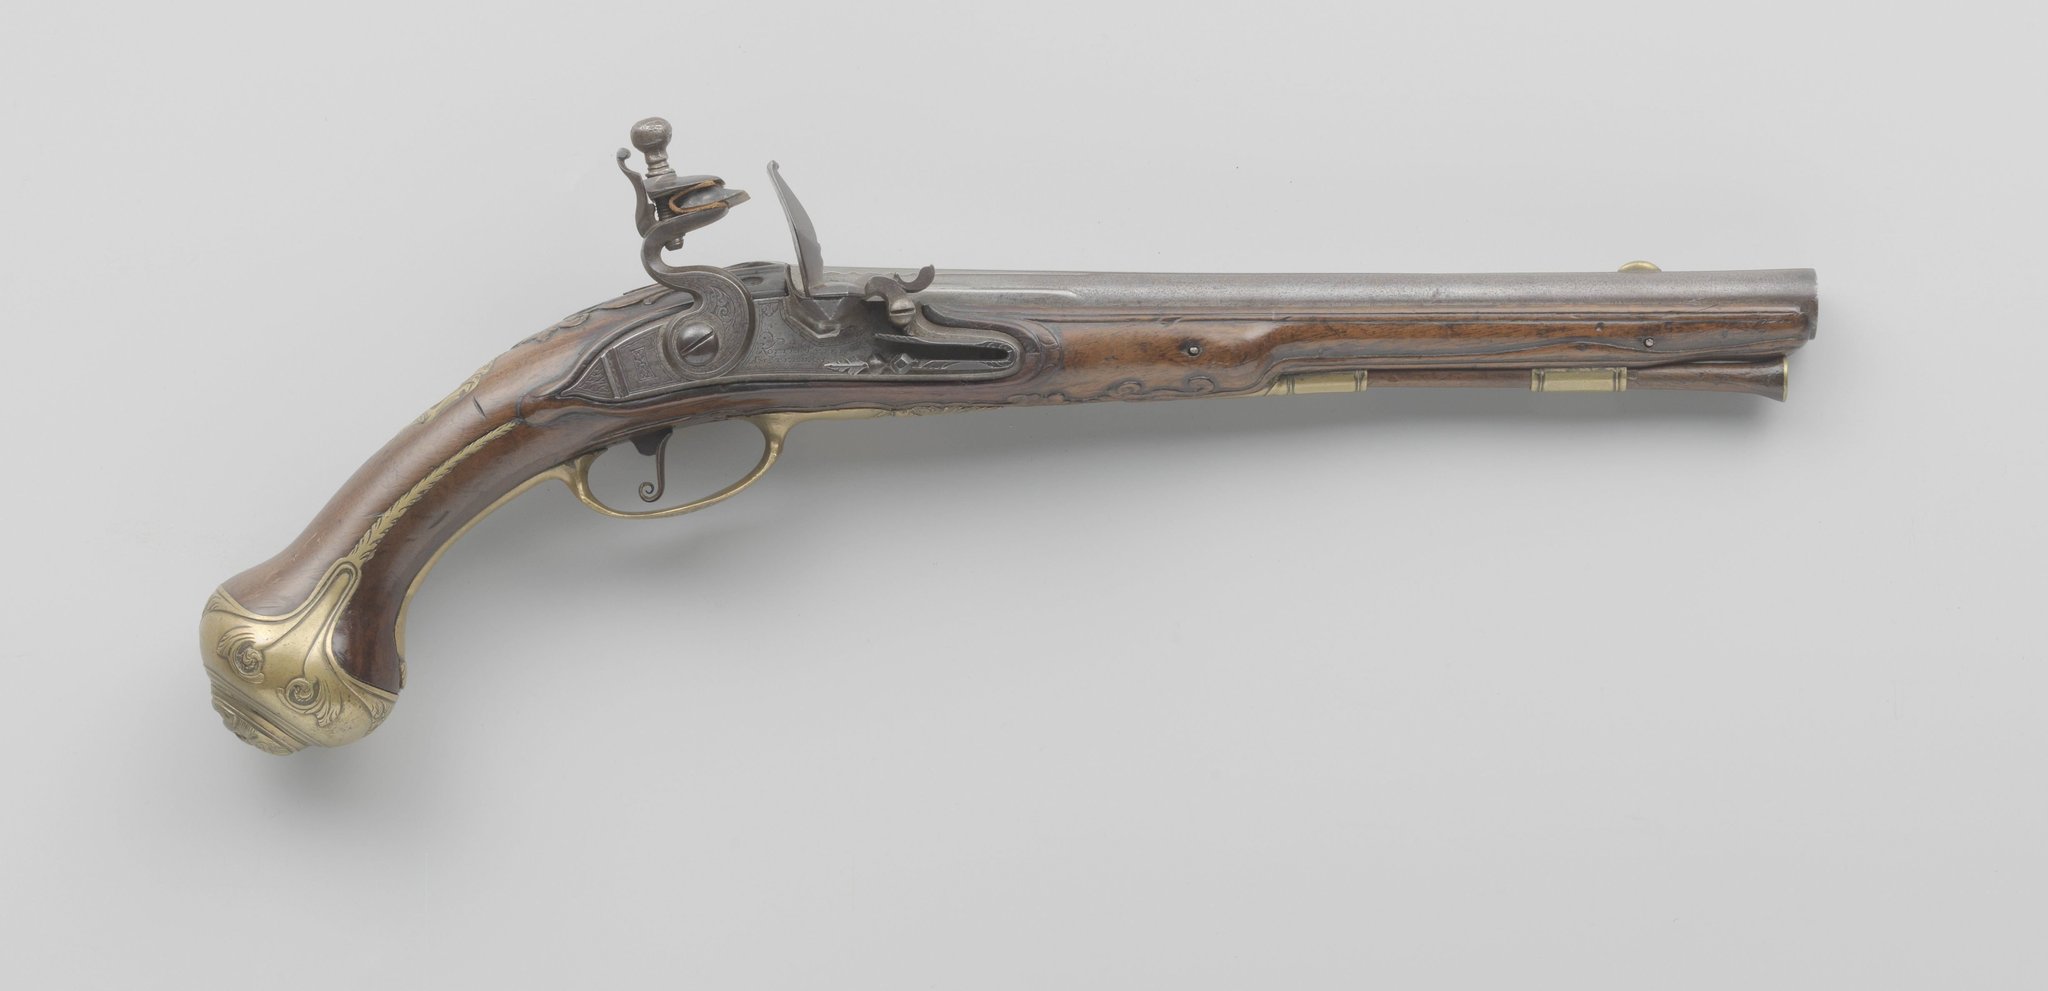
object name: flintlock pistol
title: Vuursteenpistool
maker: koeter pijper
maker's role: geweermaker, pistoolmaker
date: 1710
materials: brass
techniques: printing, metalworking, embroidery, engraving, gilding, granulation, relief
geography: amsterdam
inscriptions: coat of arms, inscription: ‘KOETER PYPER // AMSTERDAM’